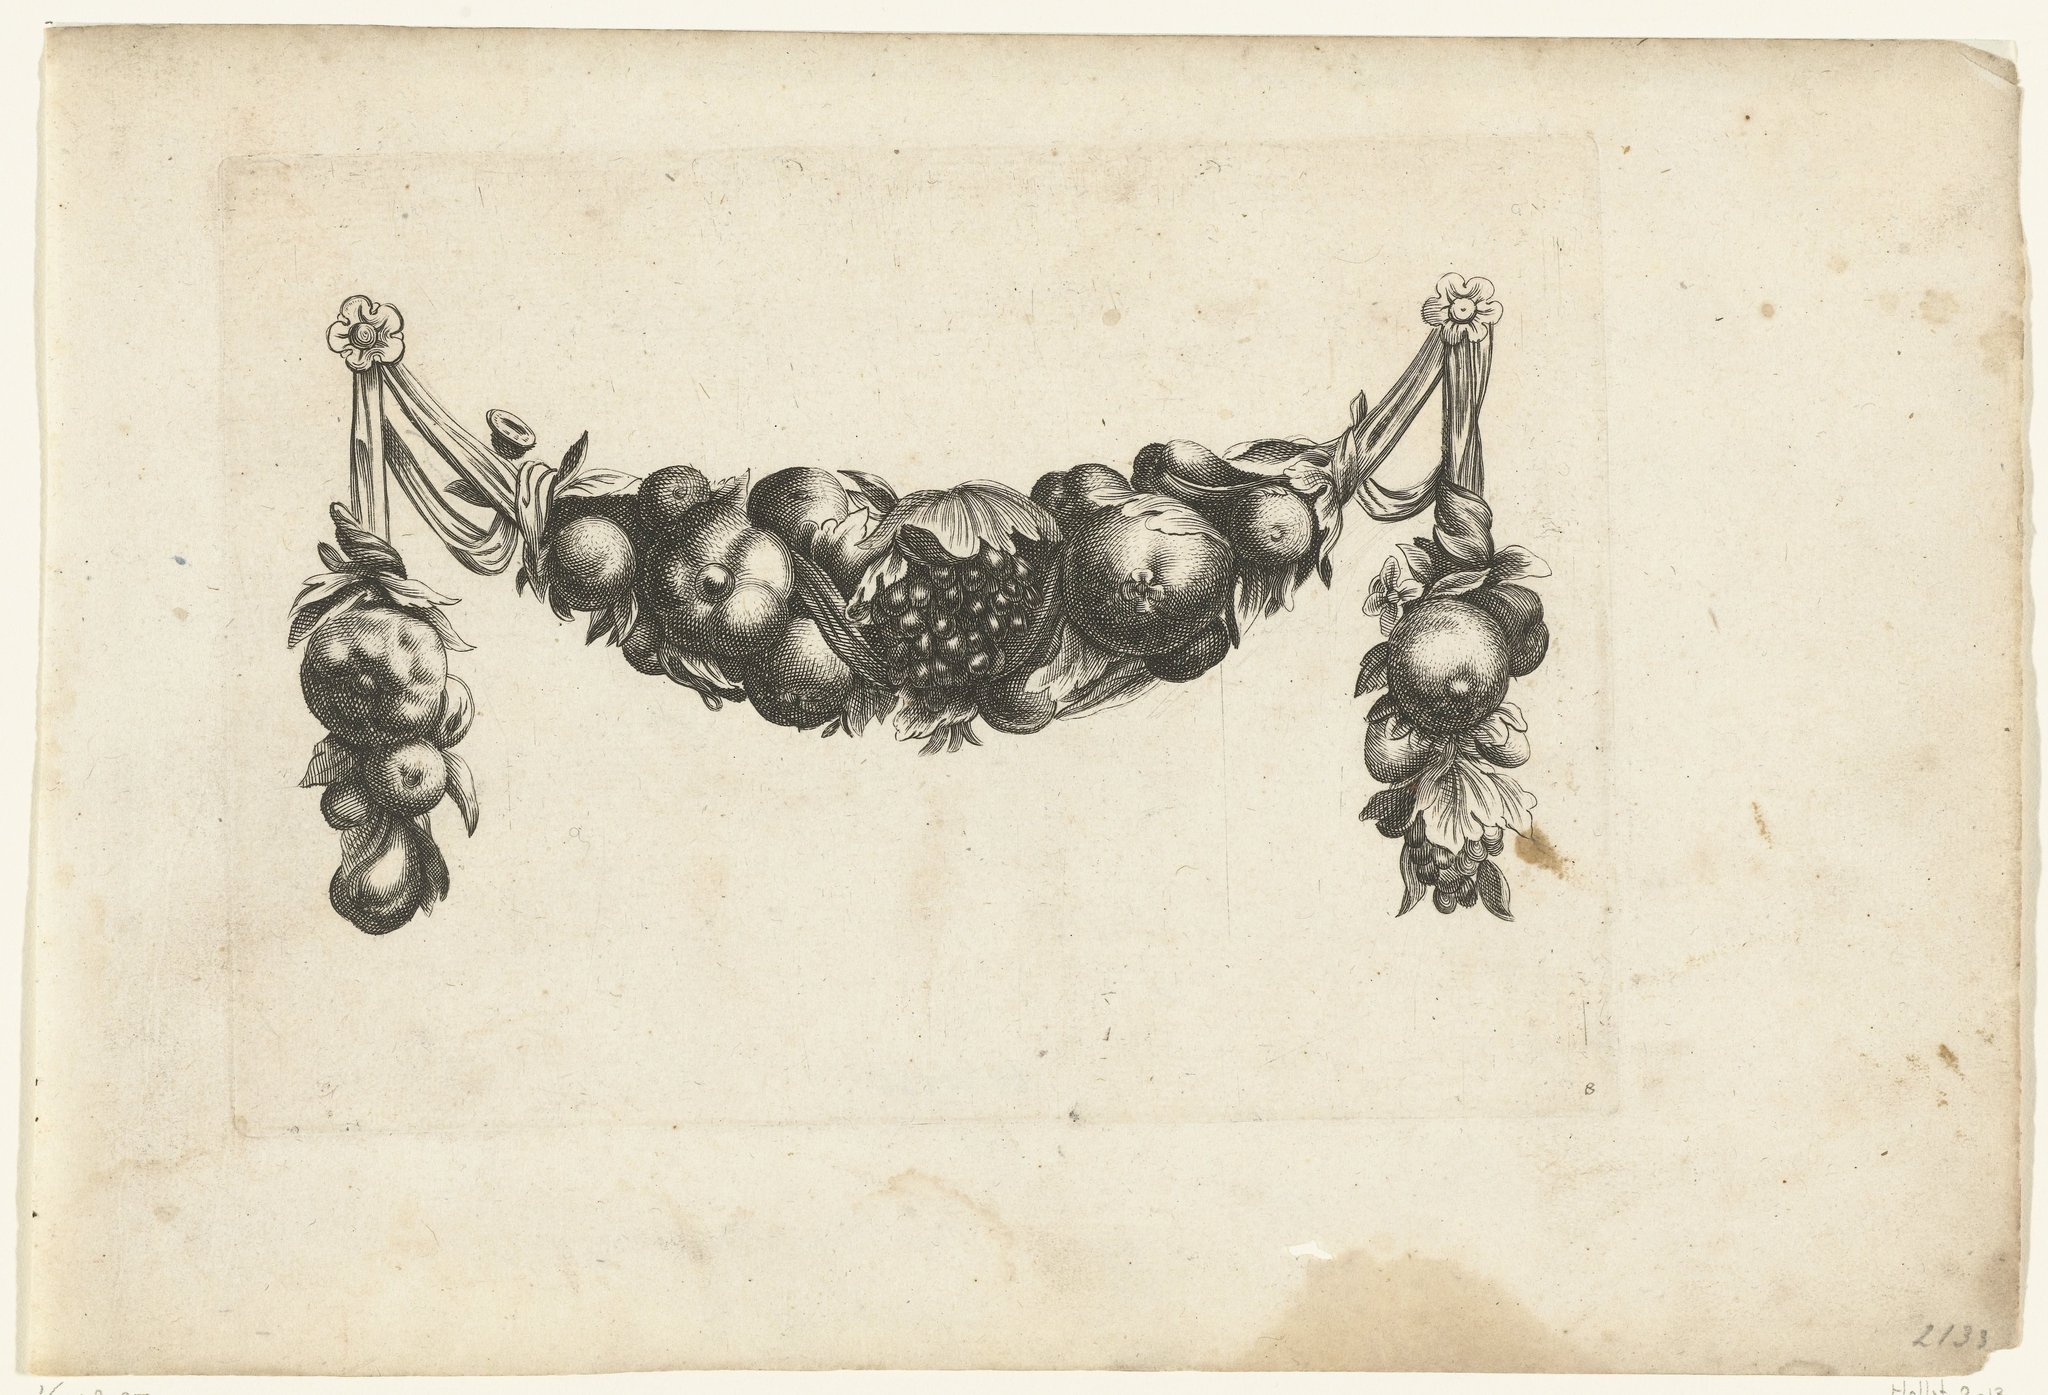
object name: ornament print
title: Festoen van fruit met een druiventros in het midden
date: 1655-1678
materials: paper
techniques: engraving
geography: amsterdam